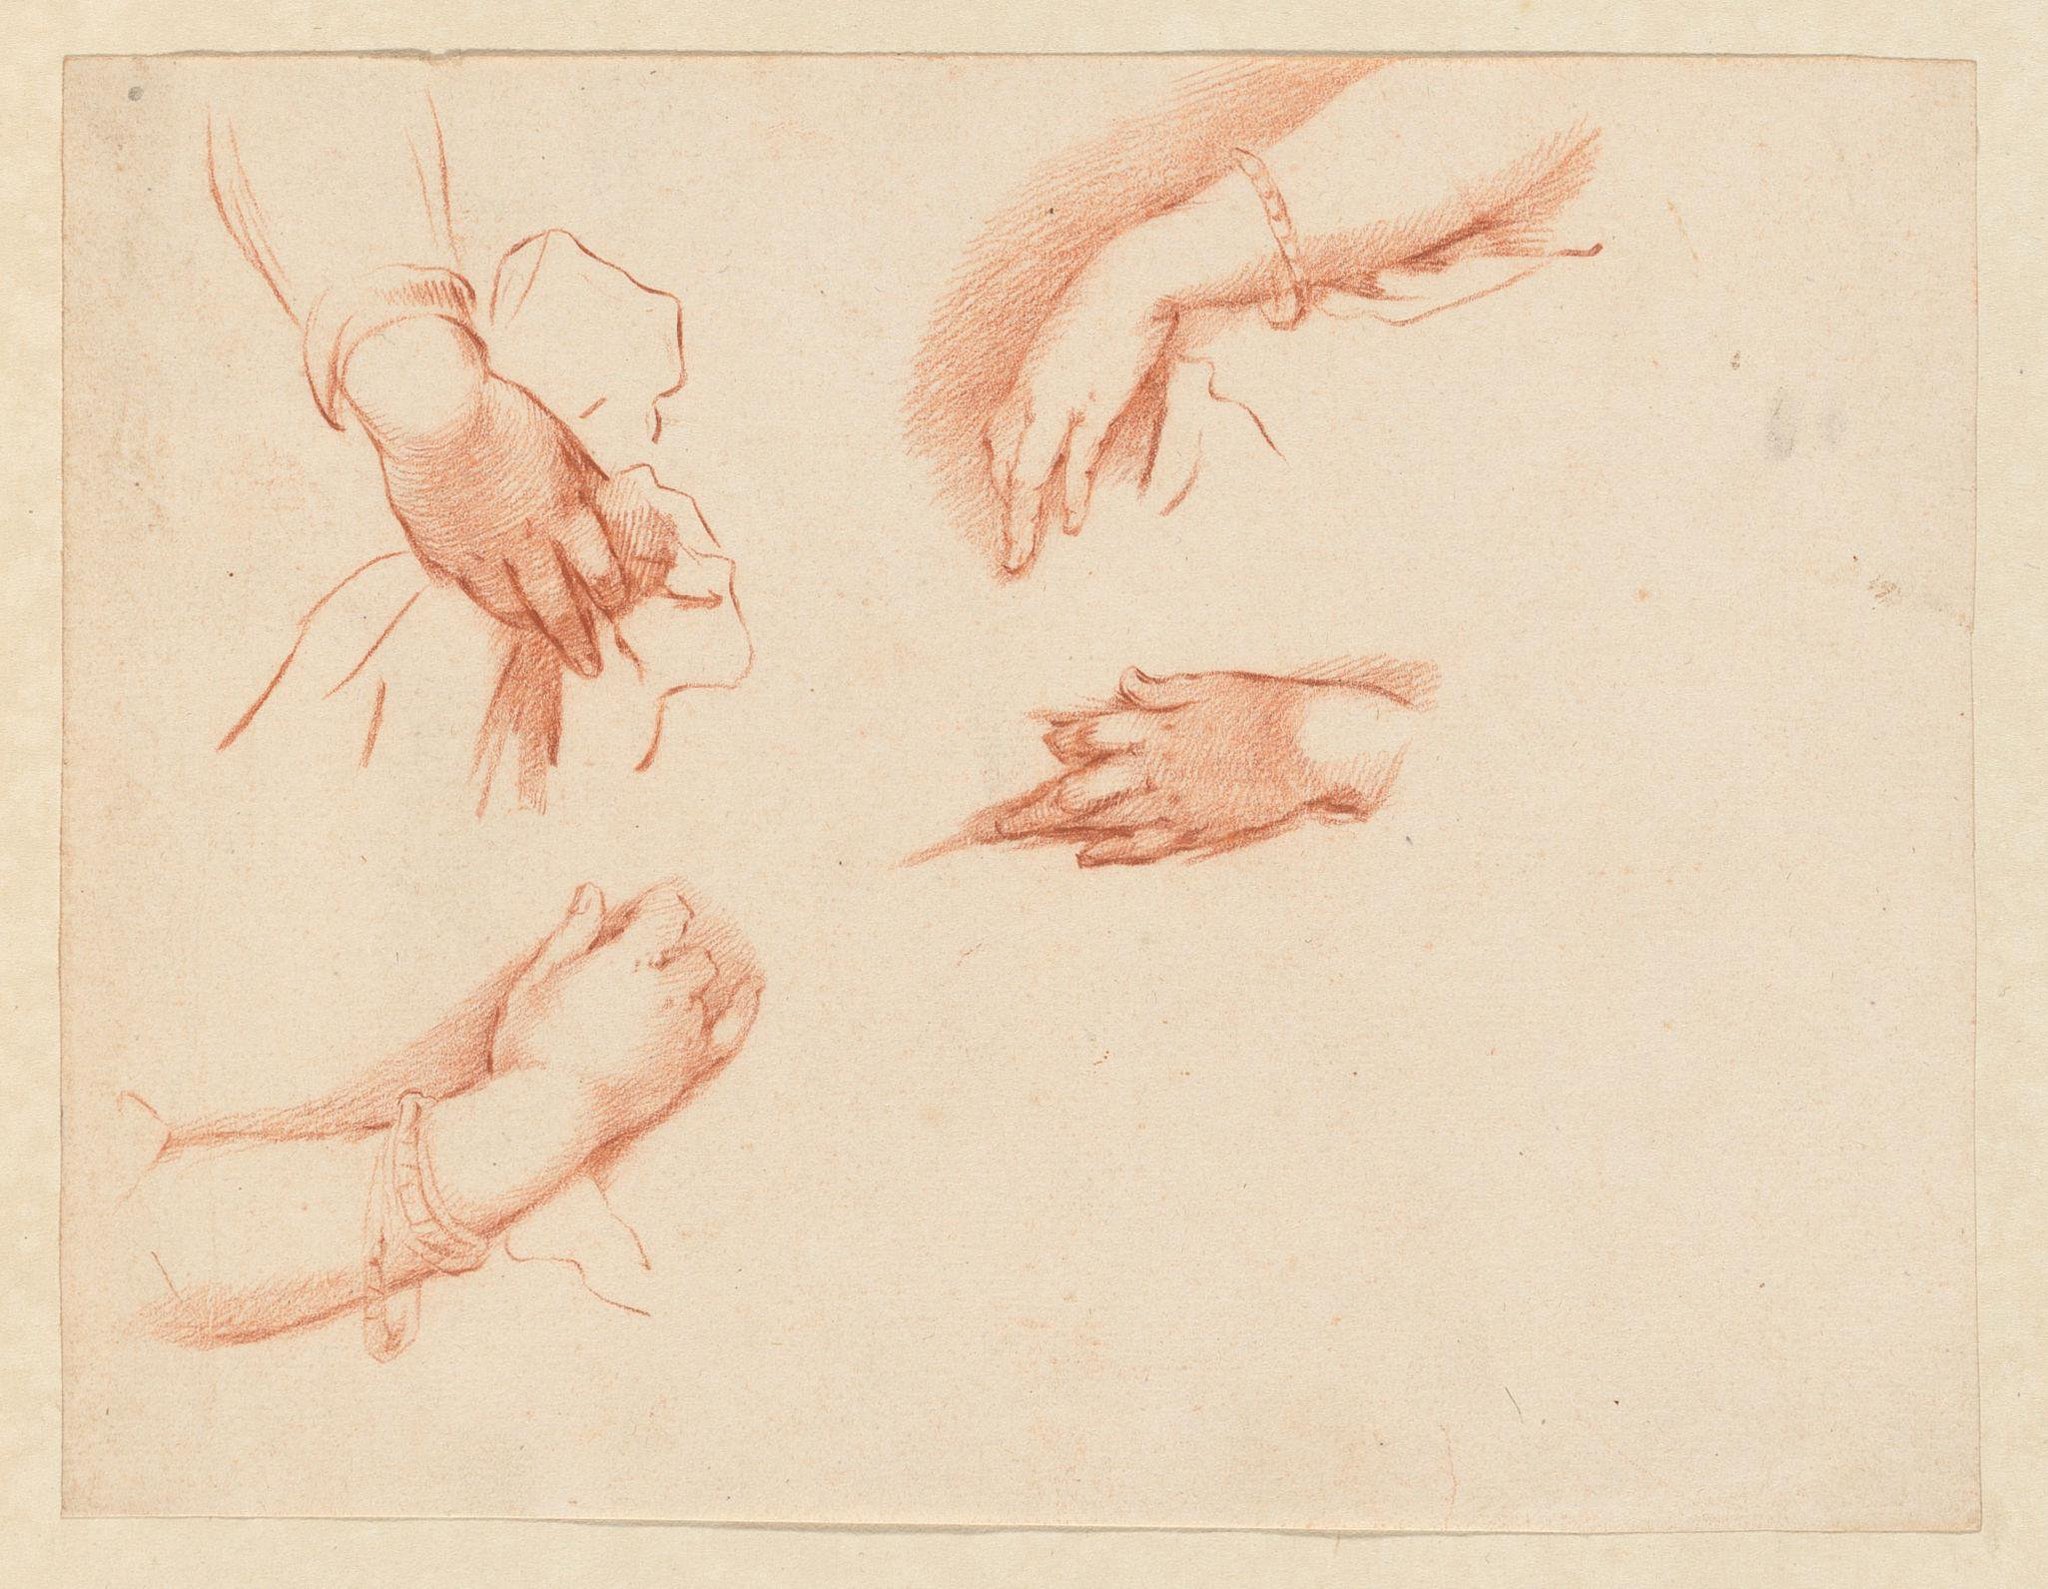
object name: drawing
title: Studie van handen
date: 1649-1723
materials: chalk, paper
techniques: pasting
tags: postures and gestures of hand and fingers